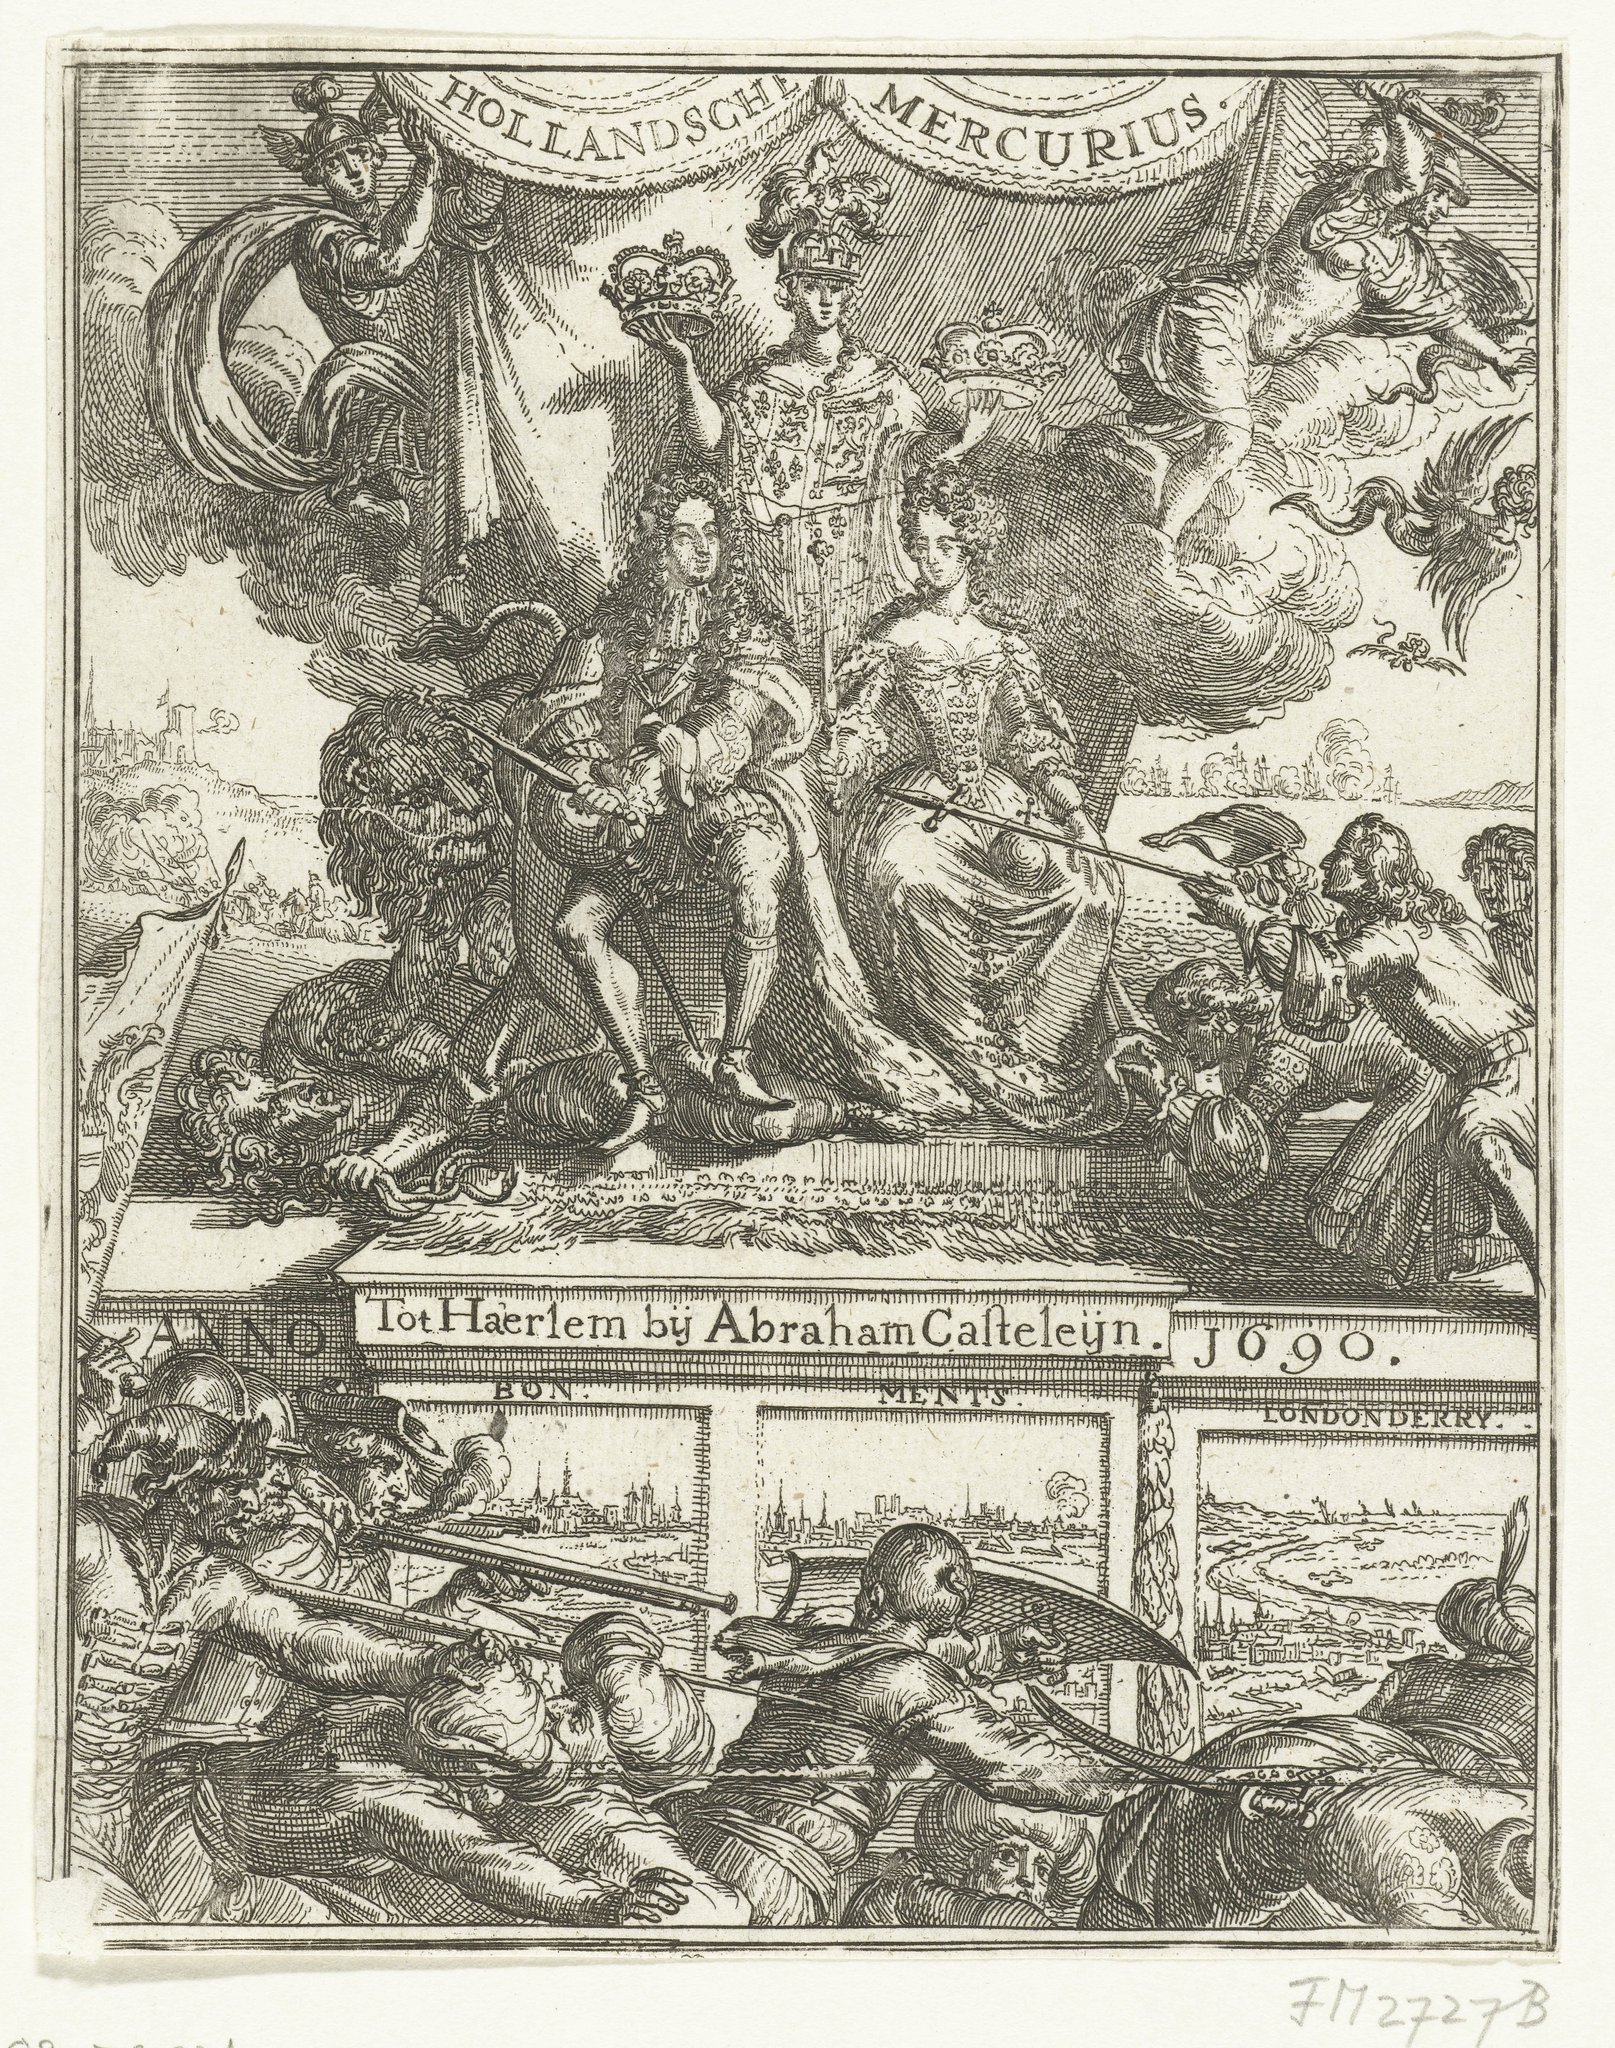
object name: print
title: Titelpagina voor de Hollandsche Mercurius over het jaar 1689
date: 1690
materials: paper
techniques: etching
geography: haarlem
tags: the hague, william iii (prince of orange and king of england, scotland, and ireland), london, maria ii stuart (koningin van engeland, schotland en ierland), specific aspects, allegorical aspects of mercury; mercury as patron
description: Titelpagina voor de Hollandsche Mercurius over het jaar 1689. Willem III en Mary gezeten op de troon en gekroond door Britannia. Op de voorgrondstrijd tegen de Turken.